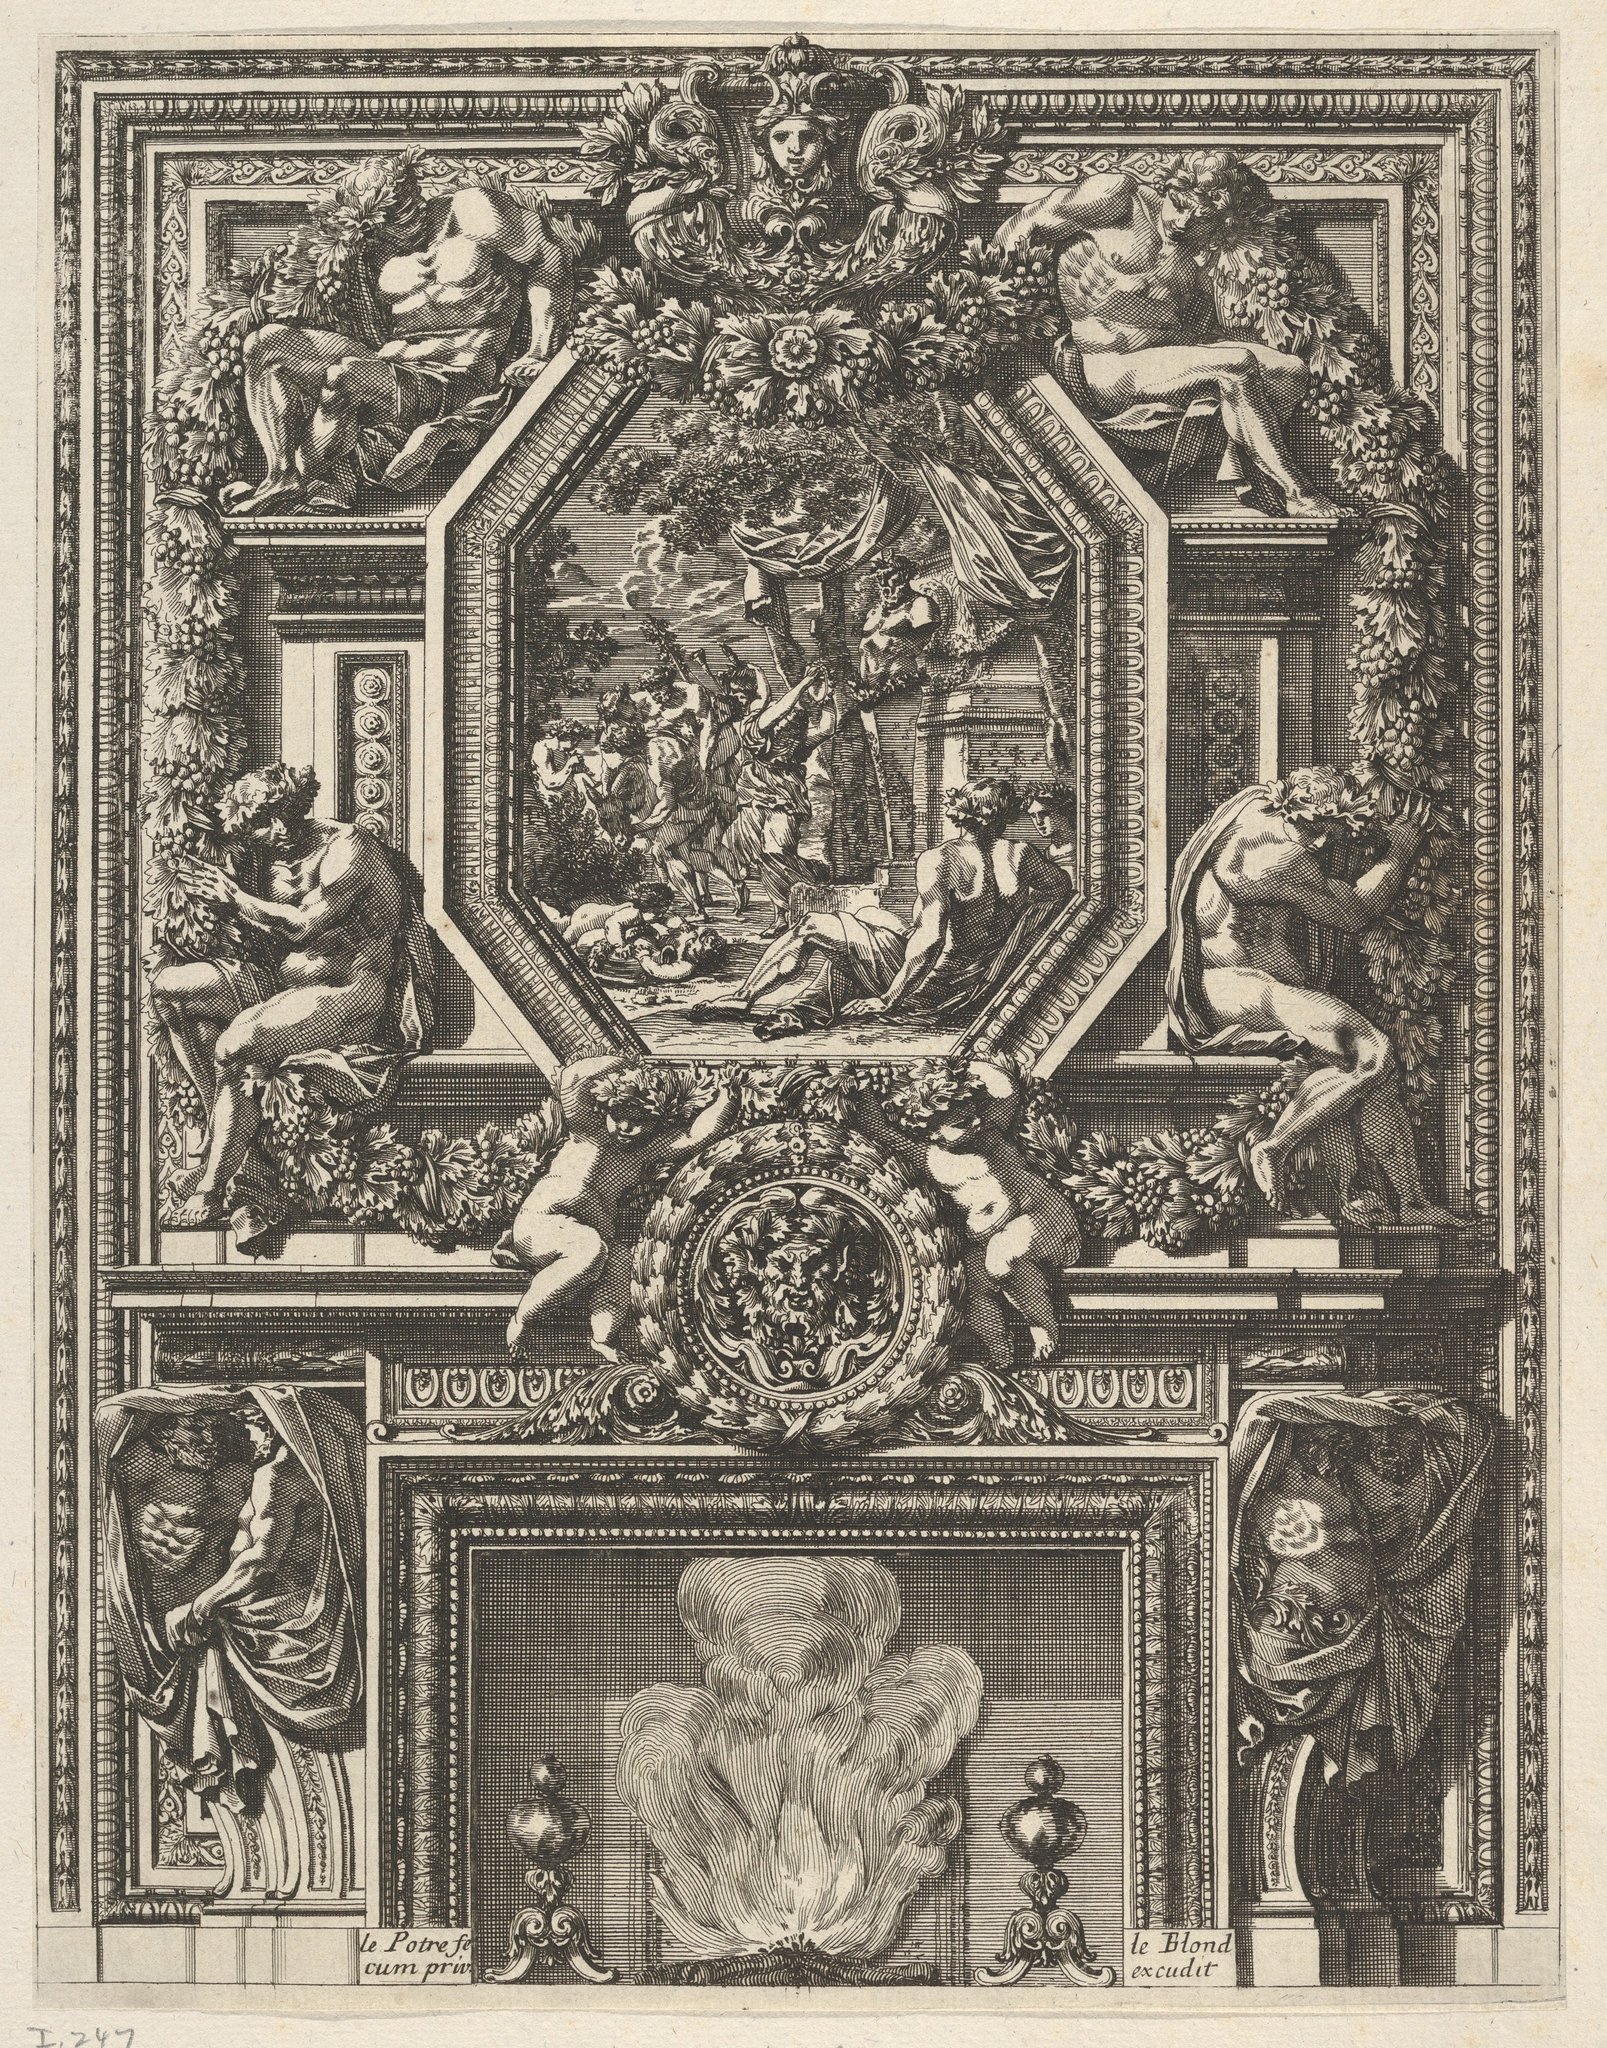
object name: print ornament architecture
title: Chimney with a Bacchanal over the Mantle from 'Grandes Cheminée'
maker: jean le pautre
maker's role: artist and engraver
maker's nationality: french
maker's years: 1618-1682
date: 1644-1666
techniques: etching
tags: garlands,men